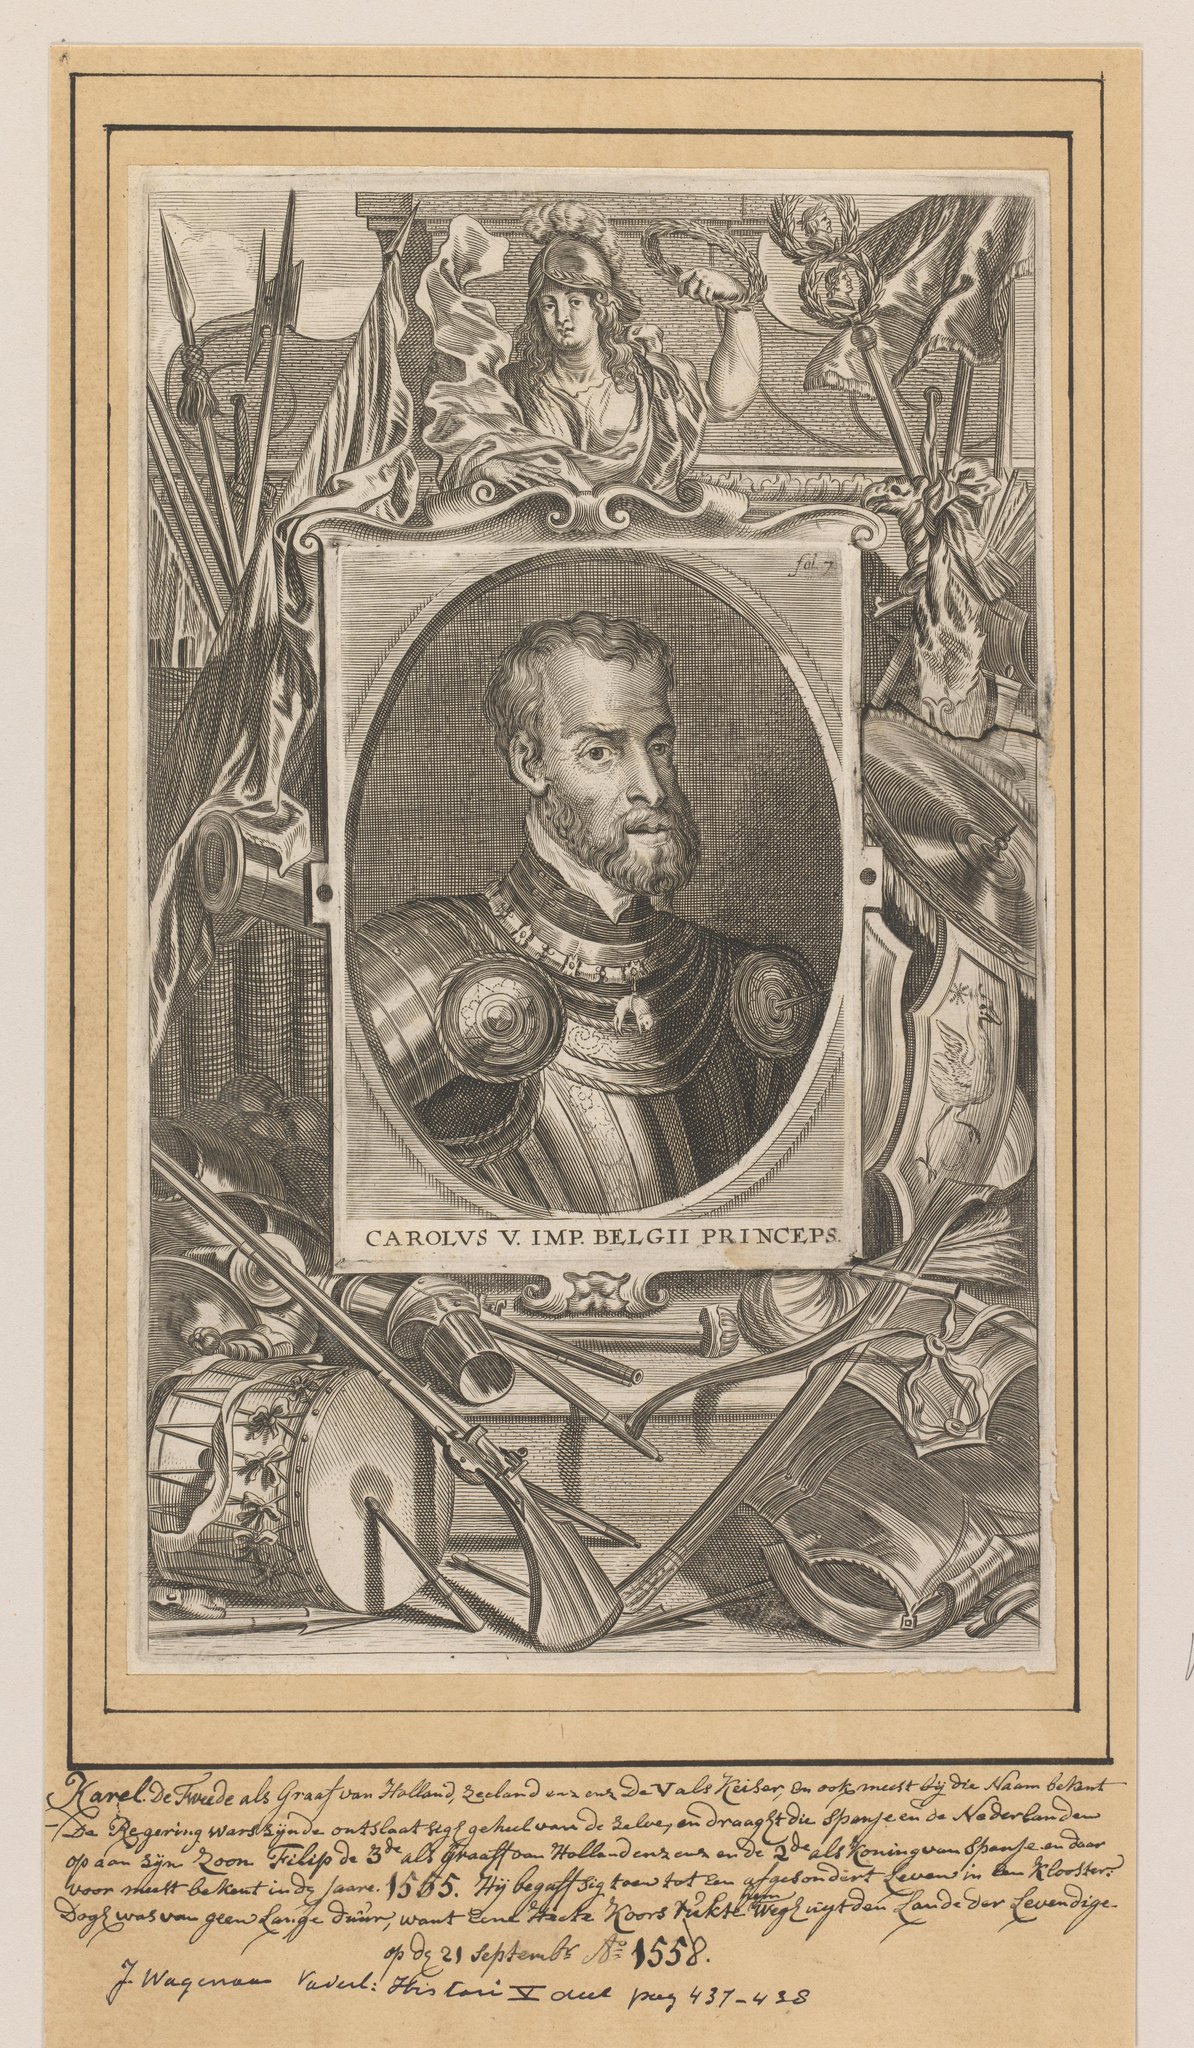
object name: print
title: Portret van keizer Karel V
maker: jacobus harrewijn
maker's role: print maker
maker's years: 1660-1740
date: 1645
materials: paper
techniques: engraving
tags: ghent, charles v (holy roman emperor and king of spain), historical persons, emperor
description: Prent waarschijnlijk uit: De thien eerste boecken der Neder-landtsche oorloghe. Antwerpen: weduwe en erfgenamen Jan Cnobbaert, 1645, p. 7.